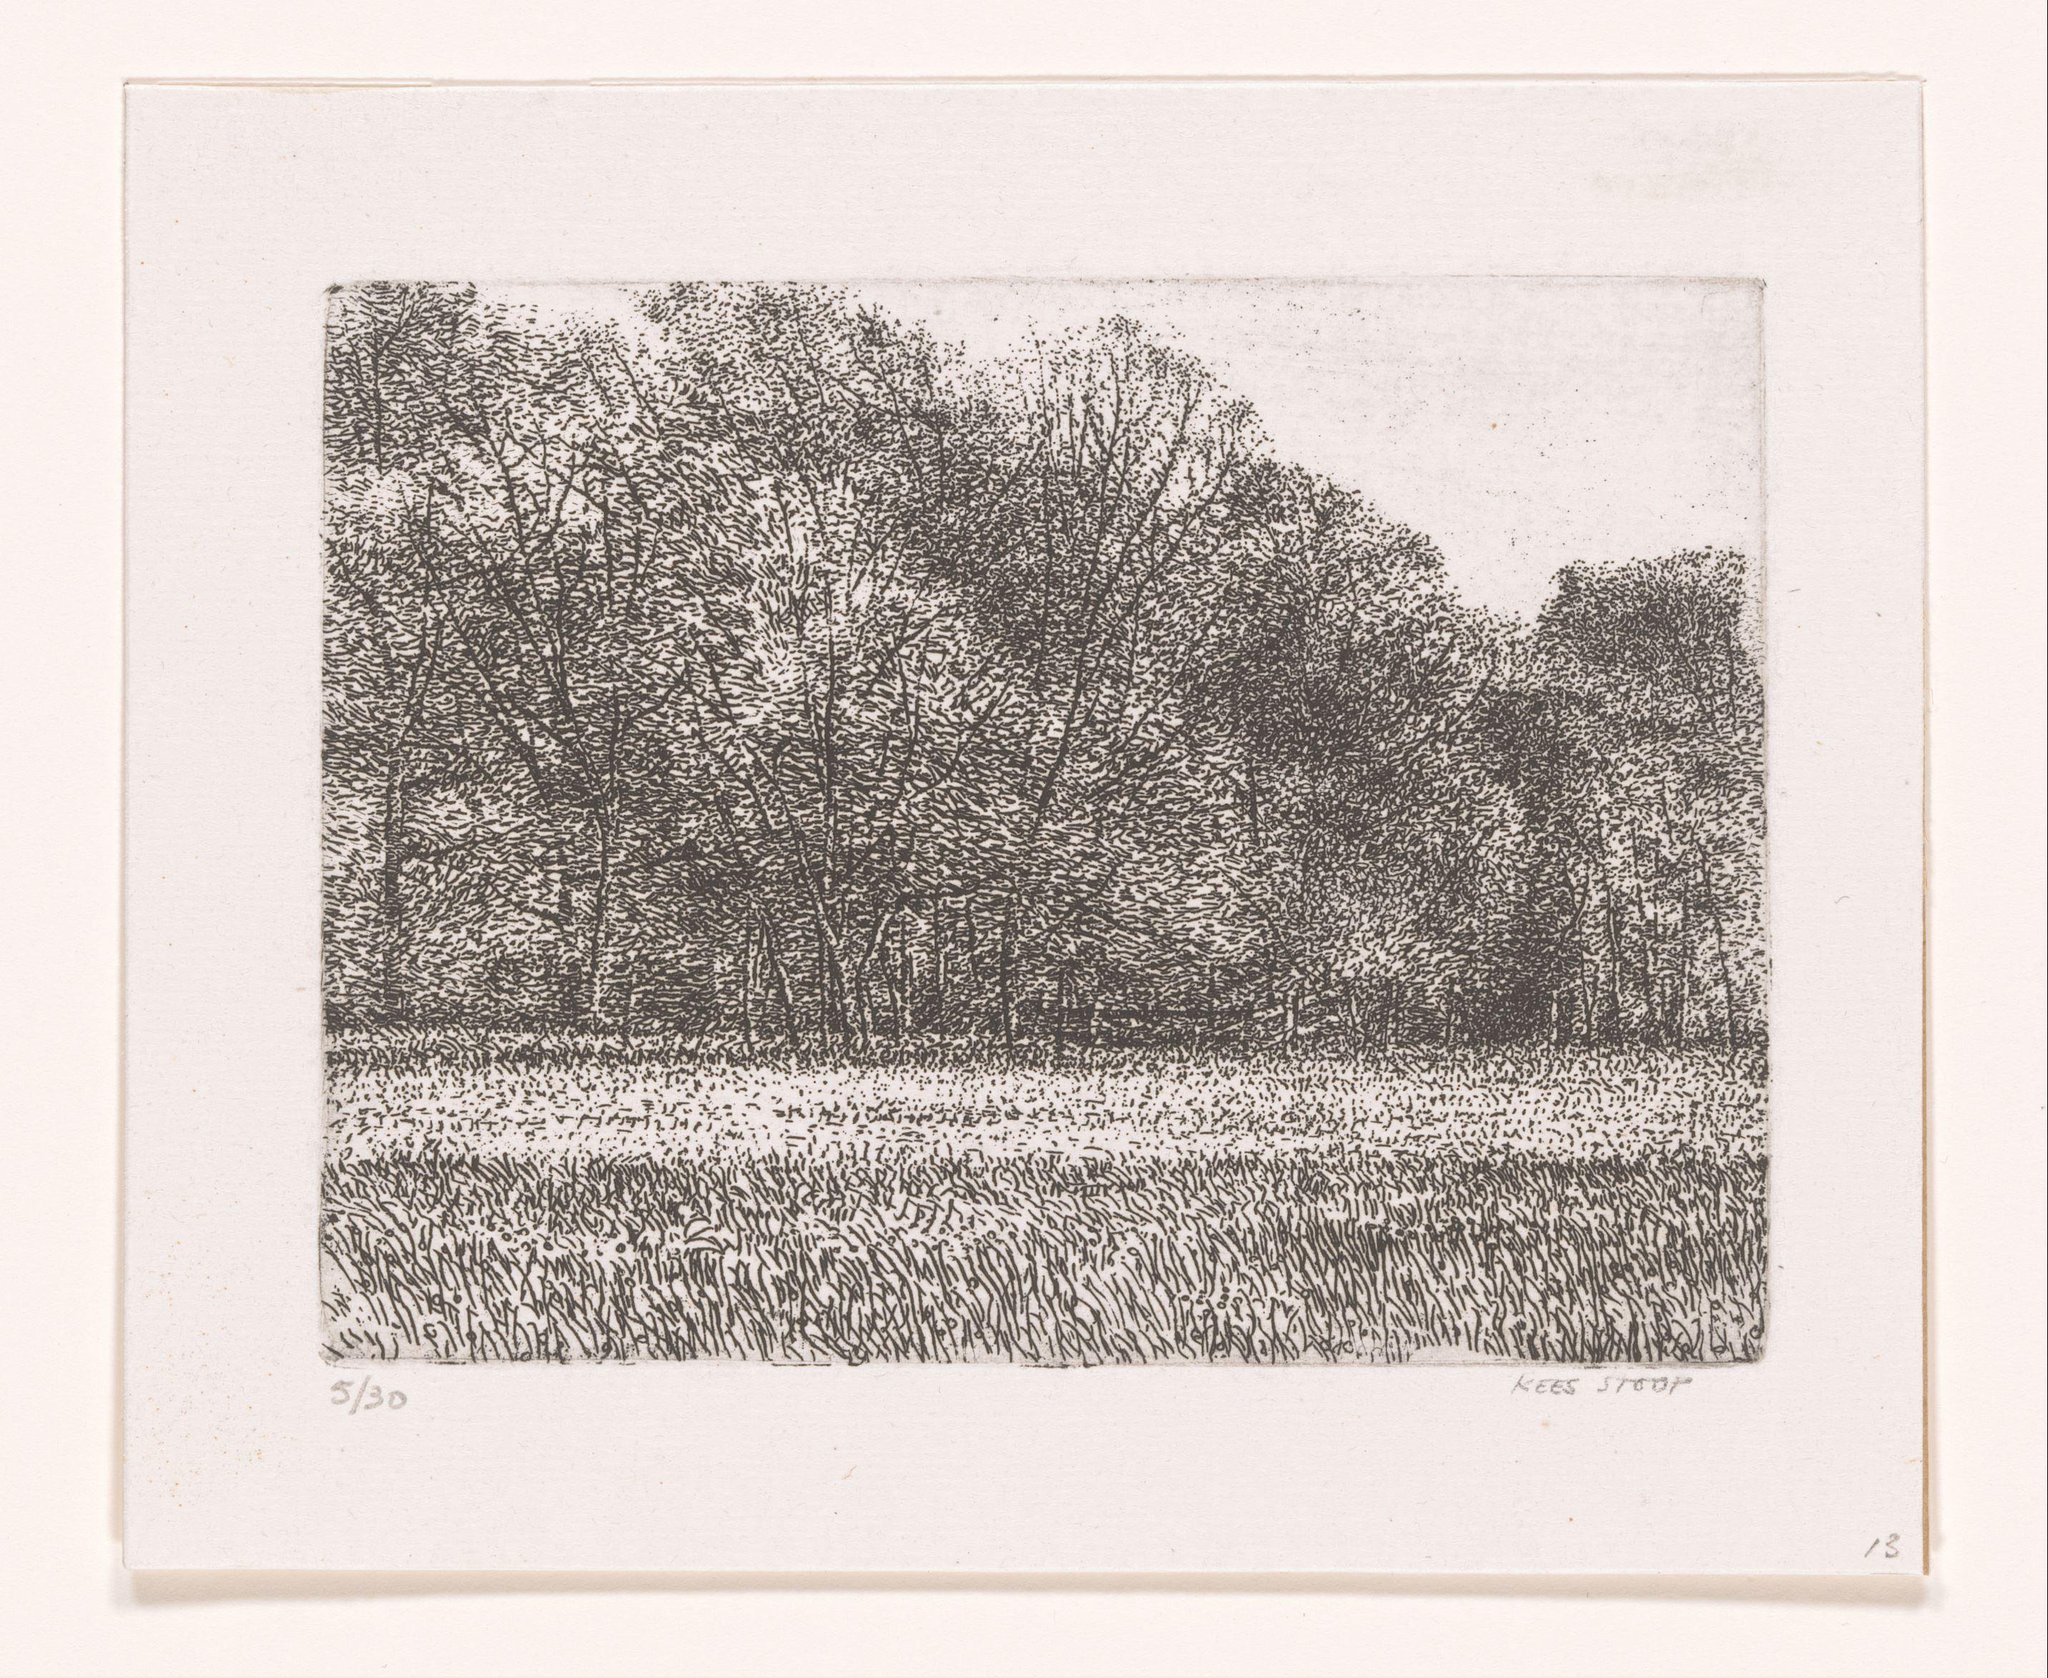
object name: print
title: Grasveld en bomen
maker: kees stoop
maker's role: draughtsman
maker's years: 1929-2019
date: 1944-1990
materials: paper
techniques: etching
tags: landscapes in the temperate zone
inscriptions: edition: ‘5/30’, signature: ‘KEES STOOP’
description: Grasveld op de voorgrond, op de achtergrond bomen met een dicht bladerdek.